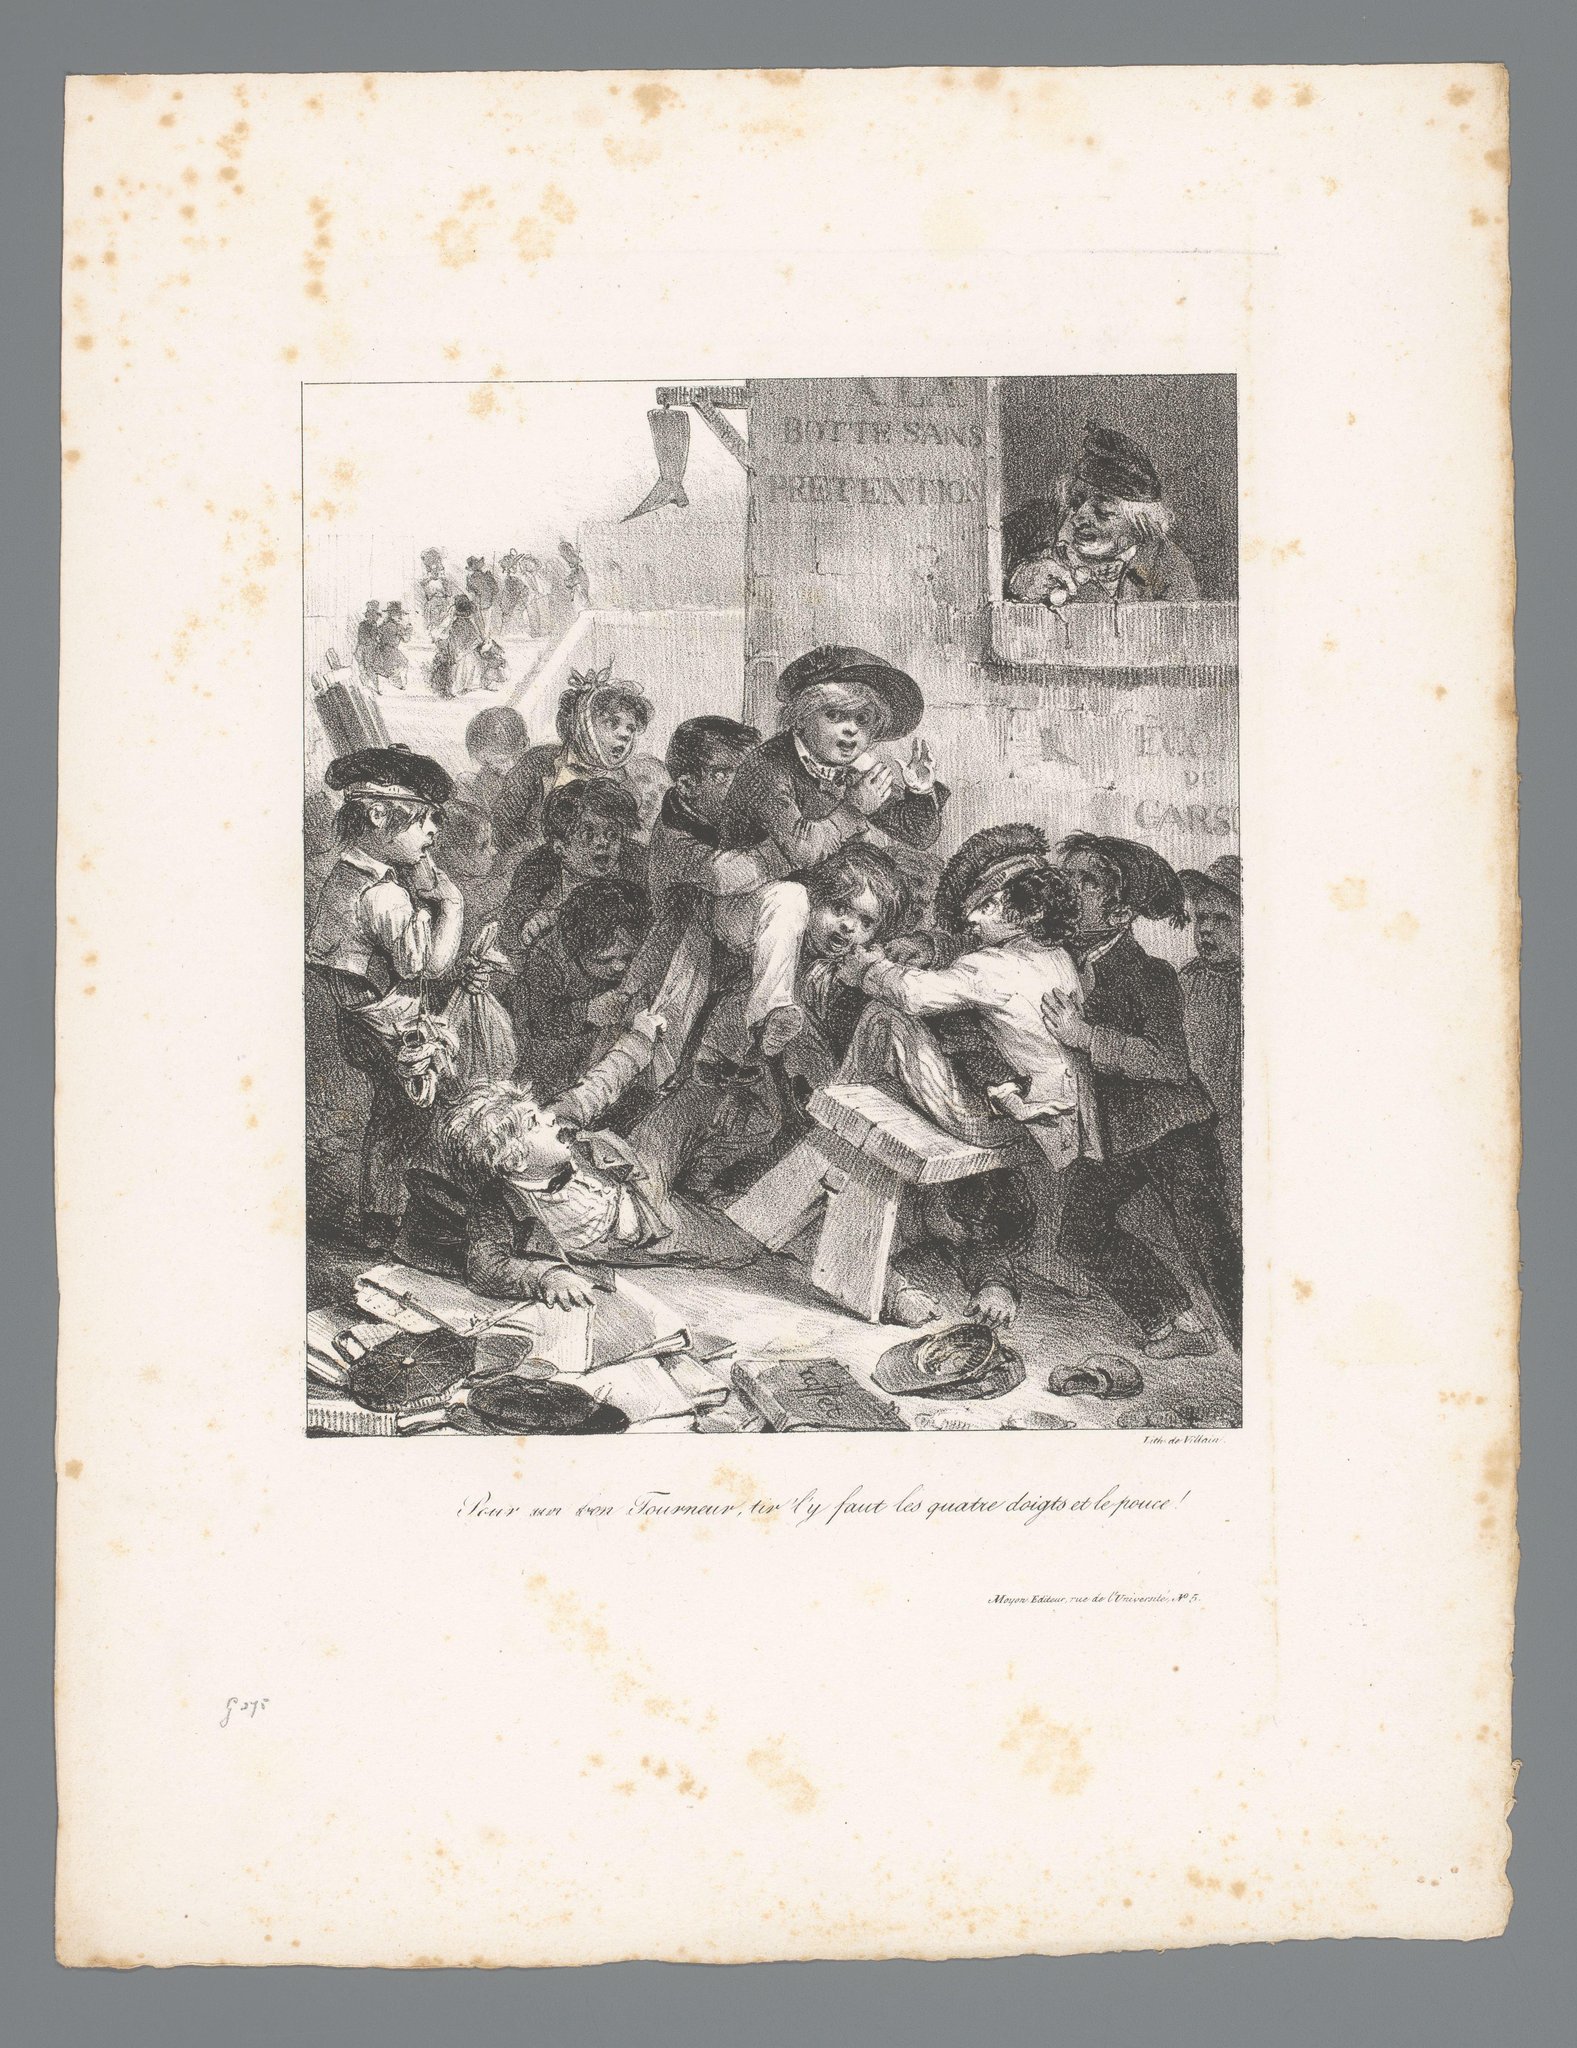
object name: print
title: Pour un bon tourneur, tir l'y faut les quatre doigts et le pouce!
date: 1827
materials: paper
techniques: lithograph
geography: paris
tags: children's games and plays, child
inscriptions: collector's mark: Lugt 964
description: Serie bestaat uit titelprent en tien prenten. Vierde prent in de serie van elf prenten.